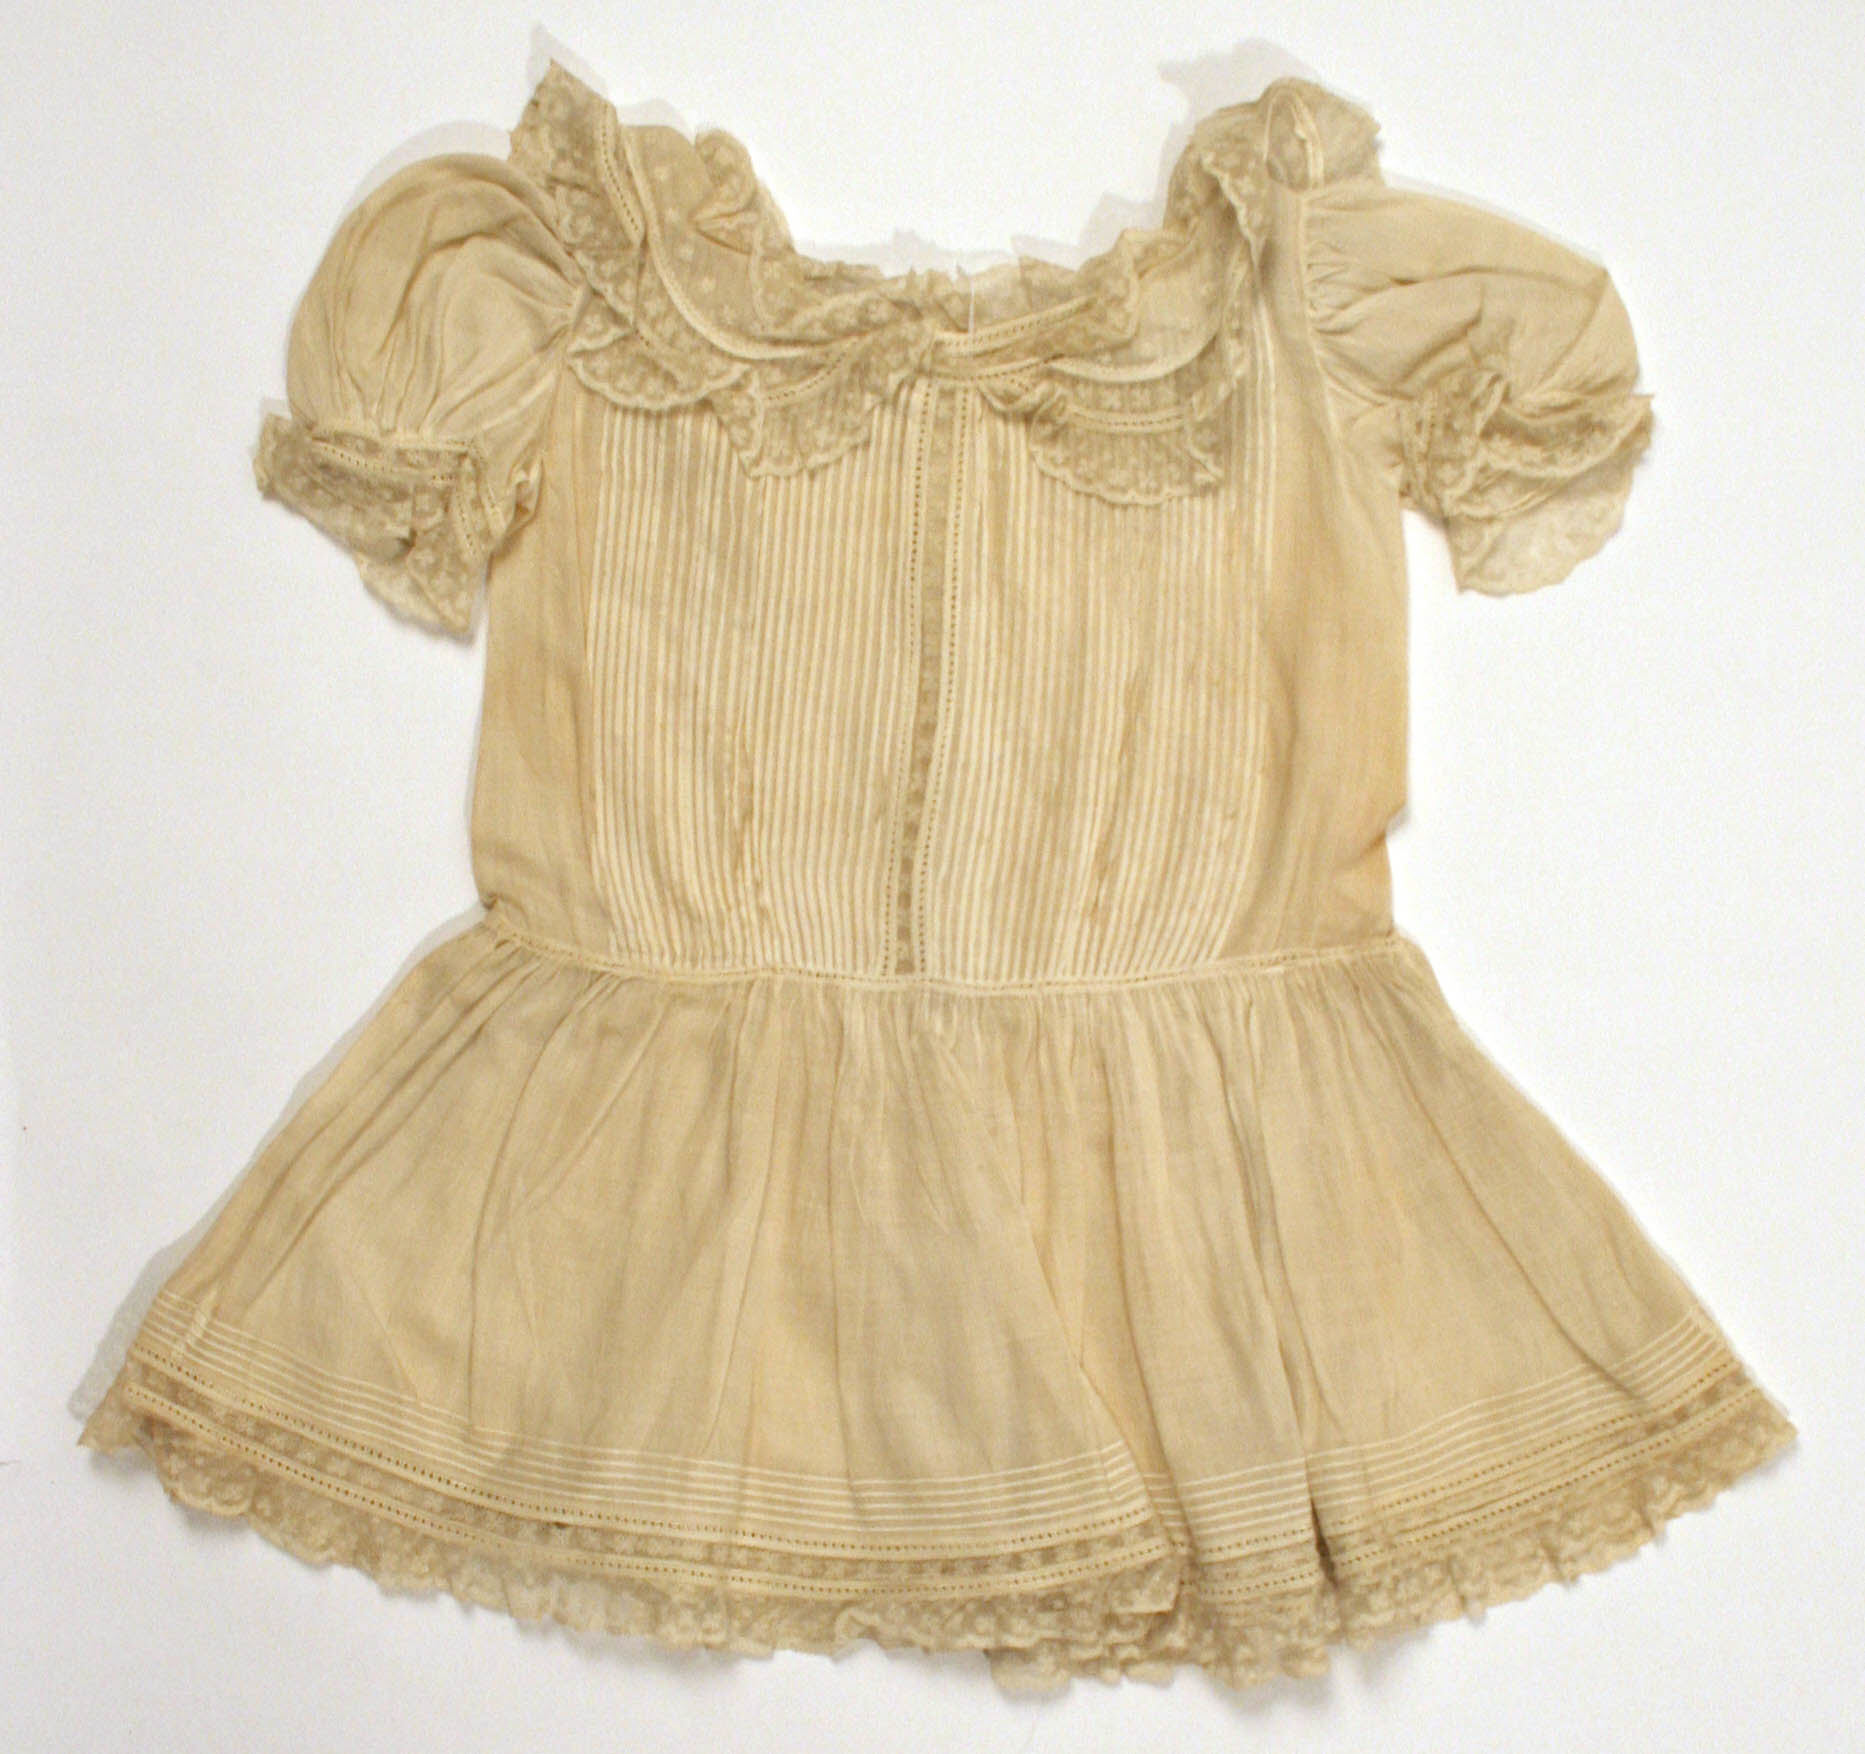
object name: dress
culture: american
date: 1903